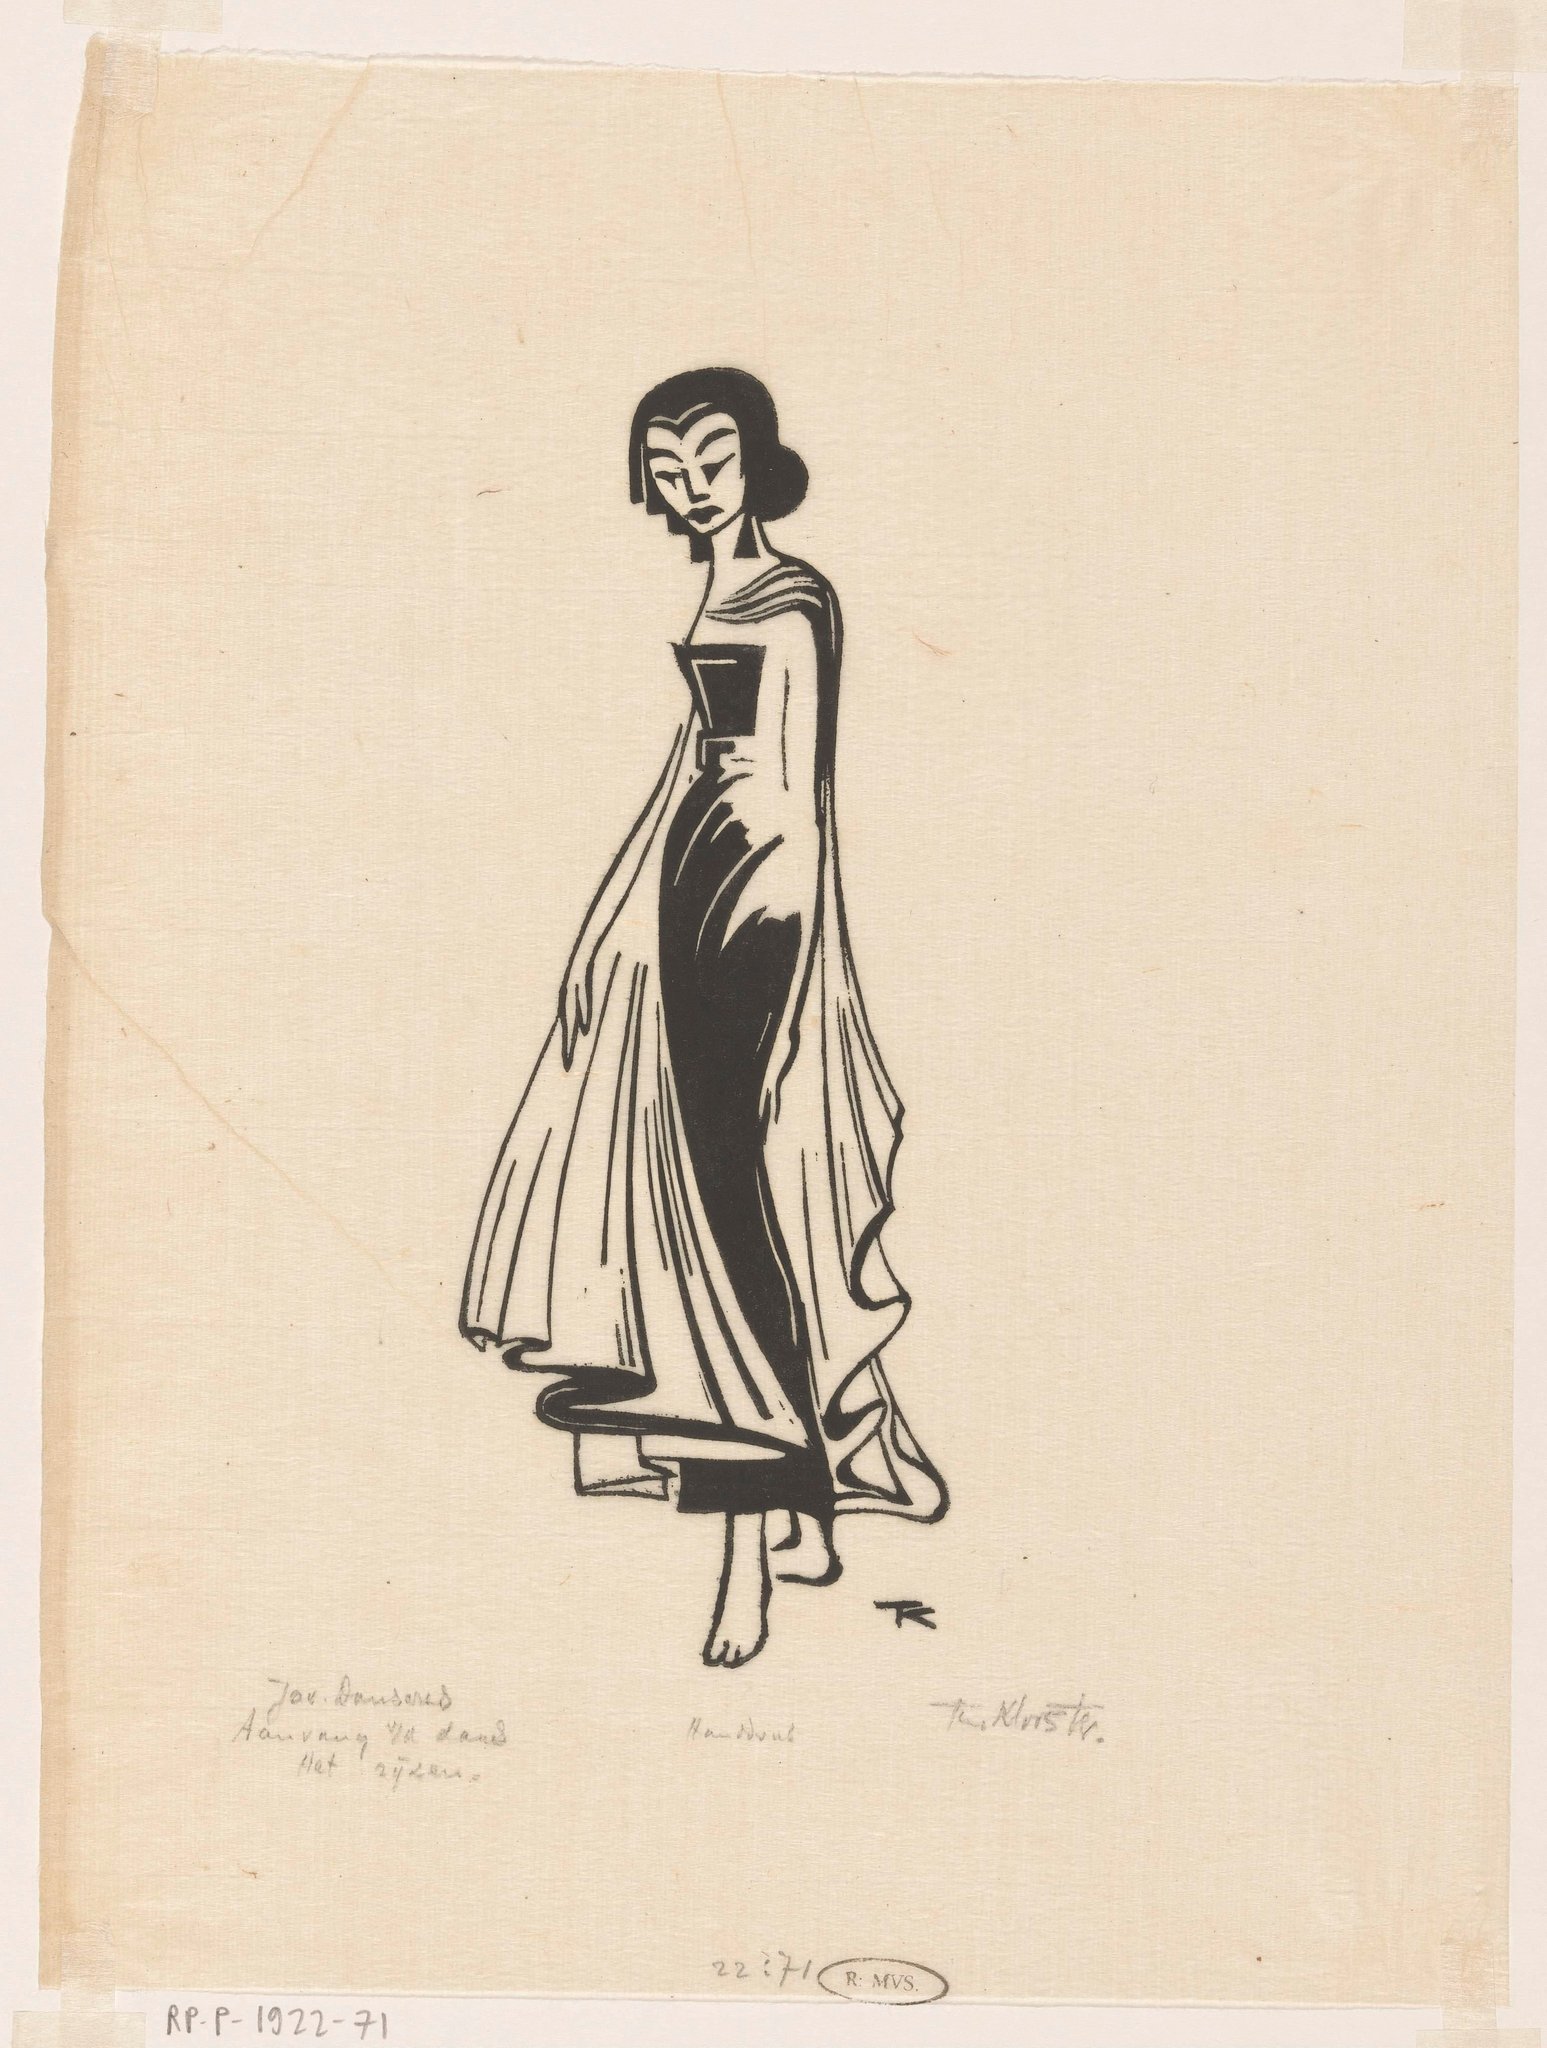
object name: print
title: Javaansche danseres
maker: johannes frederik engelbert ten klooster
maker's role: draughtsman, print maker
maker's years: 1873-1940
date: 1921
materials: paper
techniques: woodcut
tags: woman dancing alone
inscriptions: collector's mark: Lugt 2228